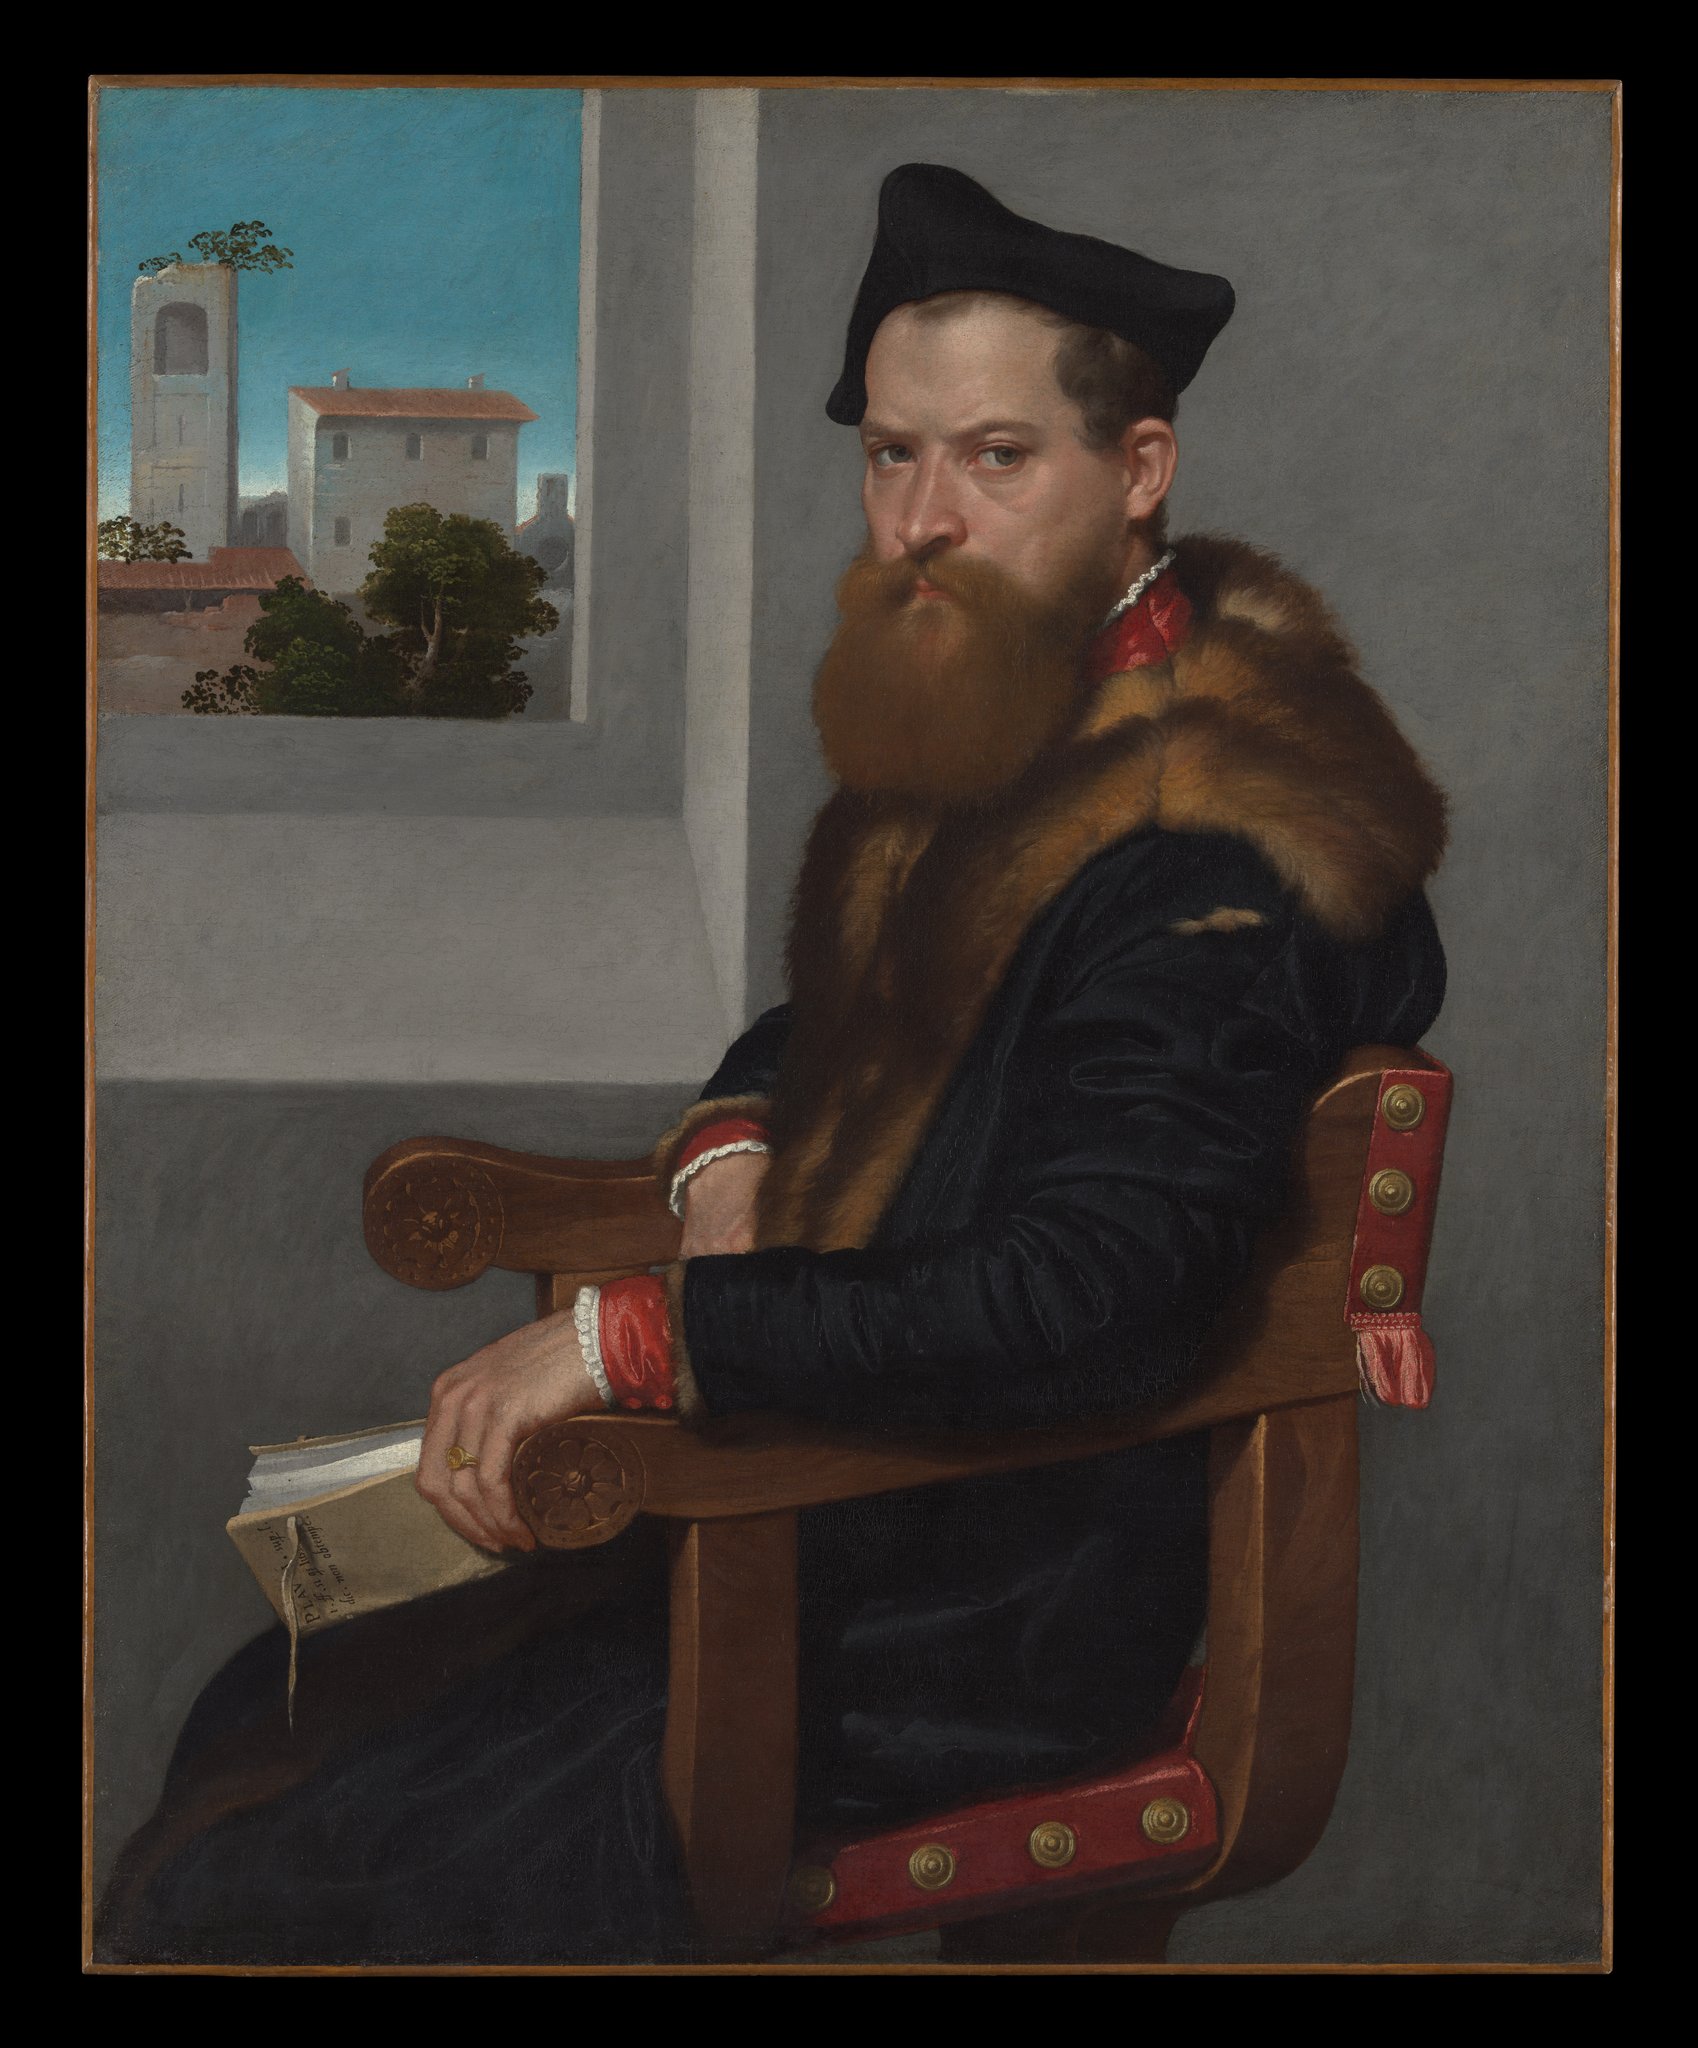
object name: painting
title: Bartolomeo Bonghi (died 1584)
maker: giovanni battista moroni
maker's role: artist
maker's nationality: italian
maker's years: 1524-1578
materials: canvas, oil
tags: men,portraits